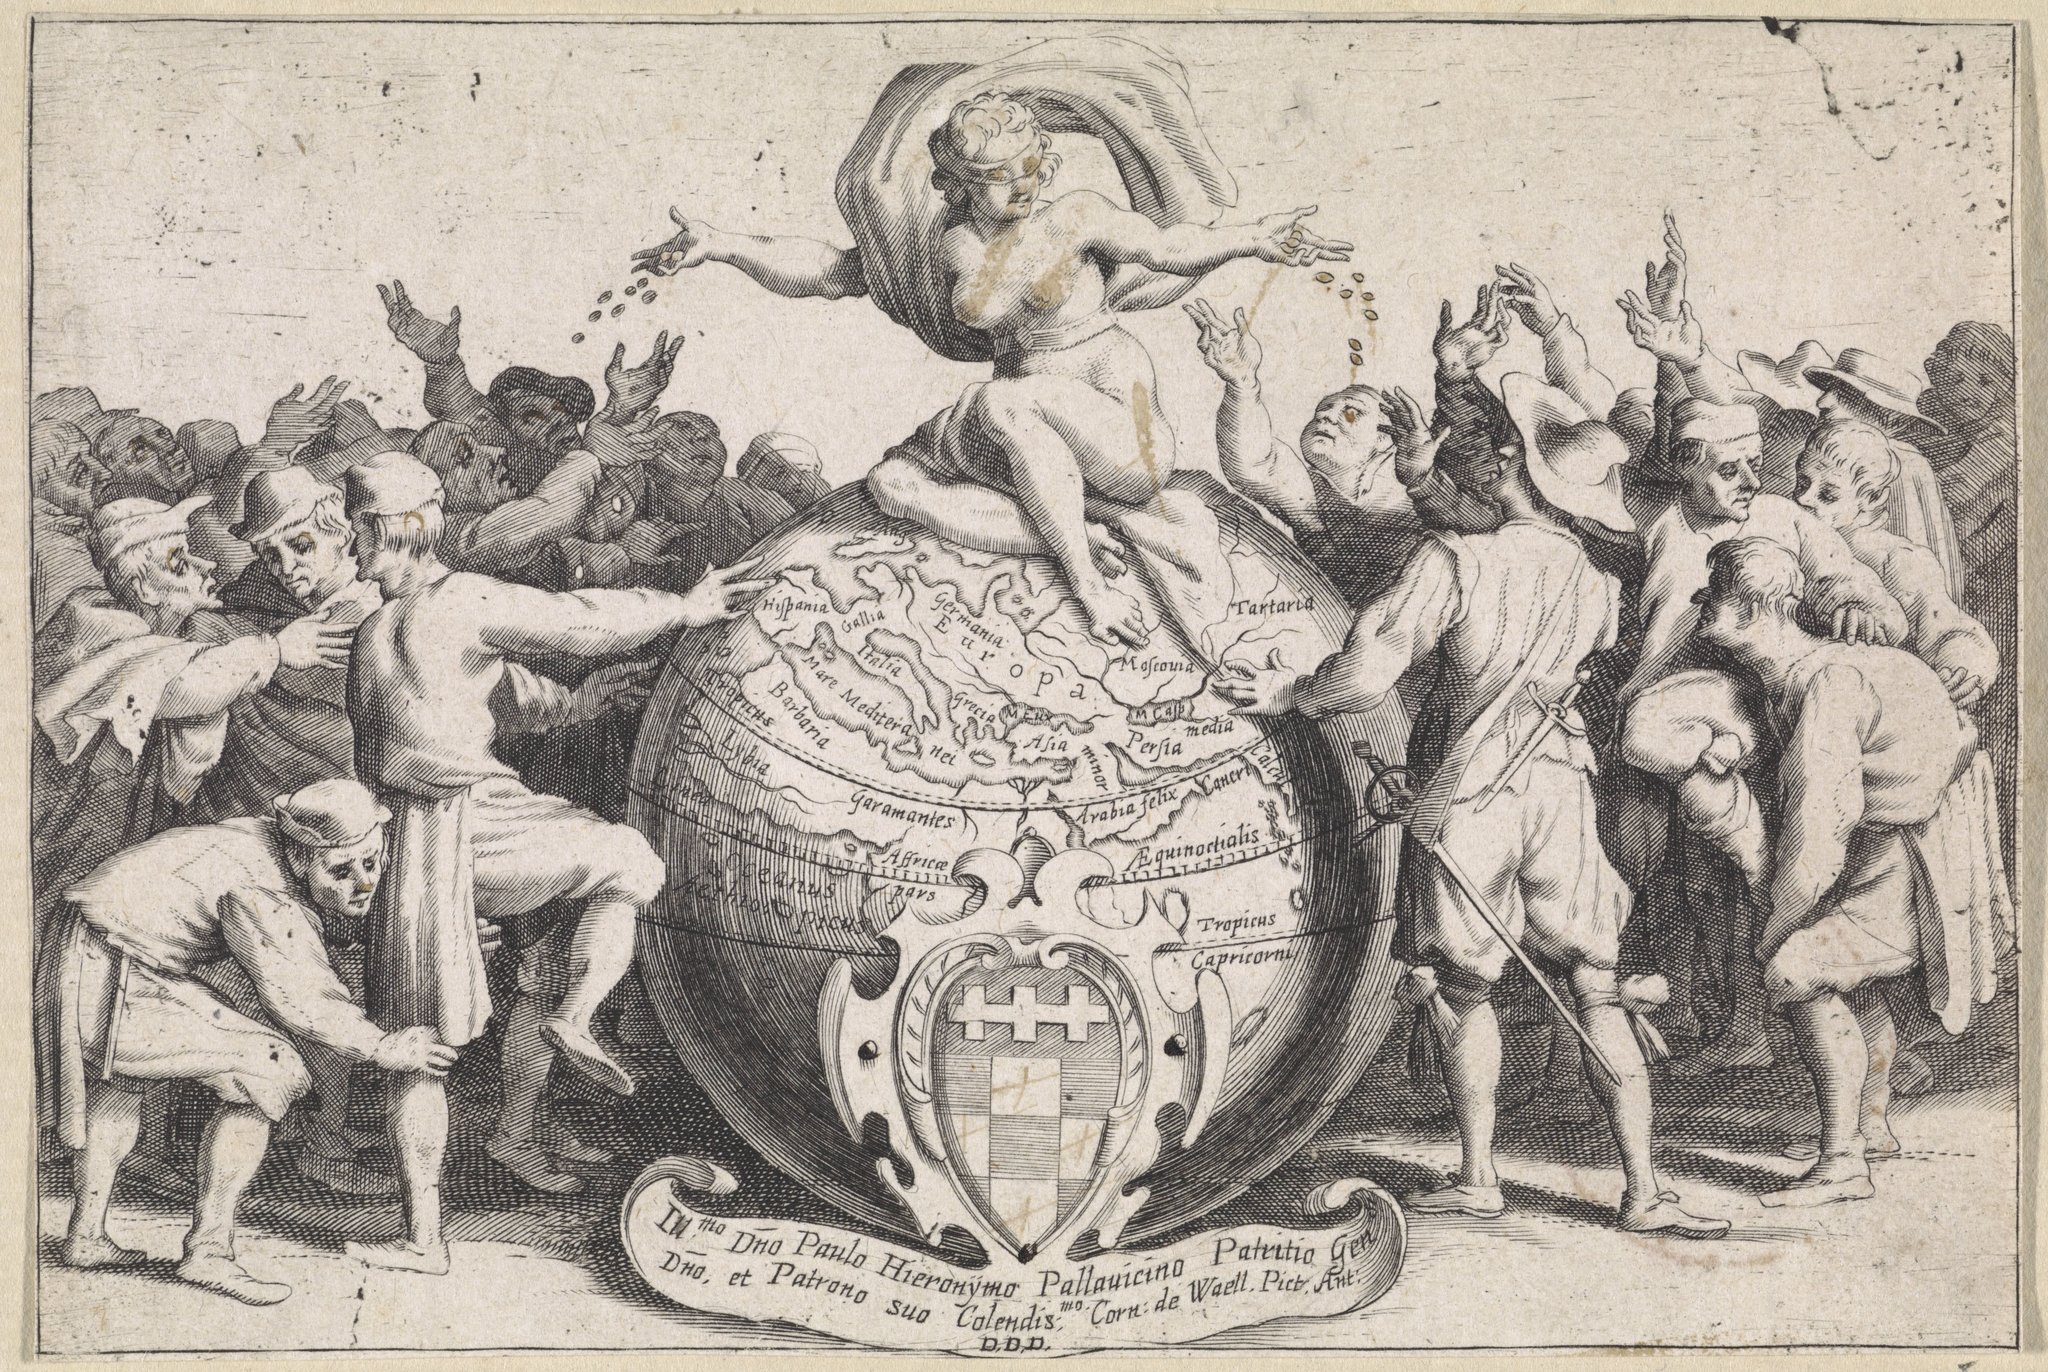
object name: print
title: Italiaanse handwerkslieden en verkopers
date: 1613-1667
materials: paper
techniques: engraving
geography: genoa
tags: coin, luck, fortune, lot; 'fato', 'fortuna', 'fortuna aurea', 'fortuna buona', 'fortuna pacifica overo clemente', 'sorte' (ripa), persons engaged in trade and commerce, armorial bearing, heraldry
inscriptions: collector's mark: Lugt 240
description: De geblinddoekte Fortuna zit op een globe en strooit munten naar de handelaren die zich rond haar verzameld hebben. Zij vechten om het geld te bemachtigen. Op de voorgrond het wapenschild van Pallavicini, waaronder een banderol met een opdracht aan hem in het Latijn.